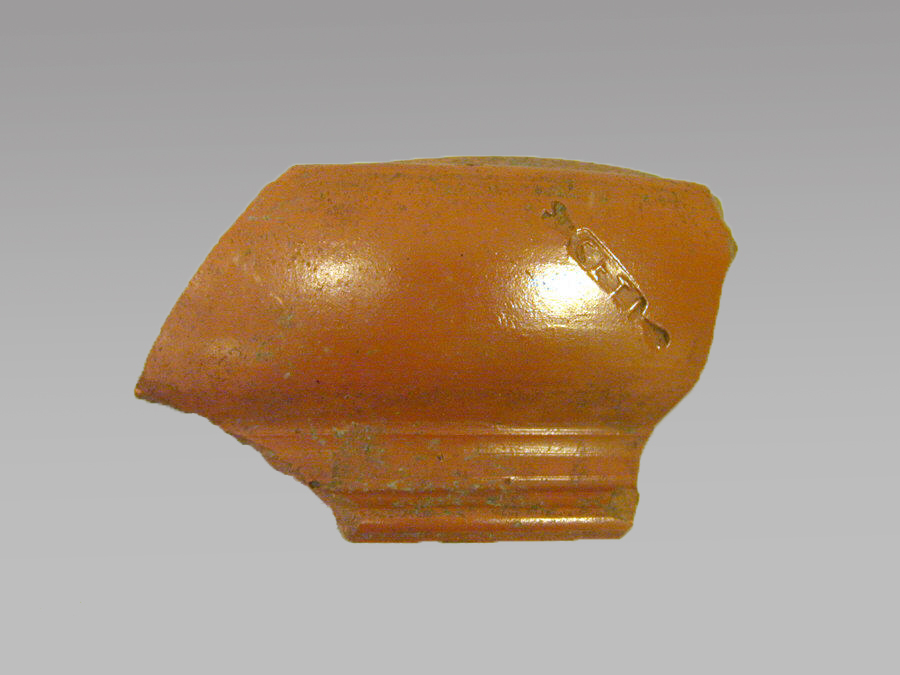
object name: vase fragment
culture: roman, gaul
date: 101-150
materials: terracotta